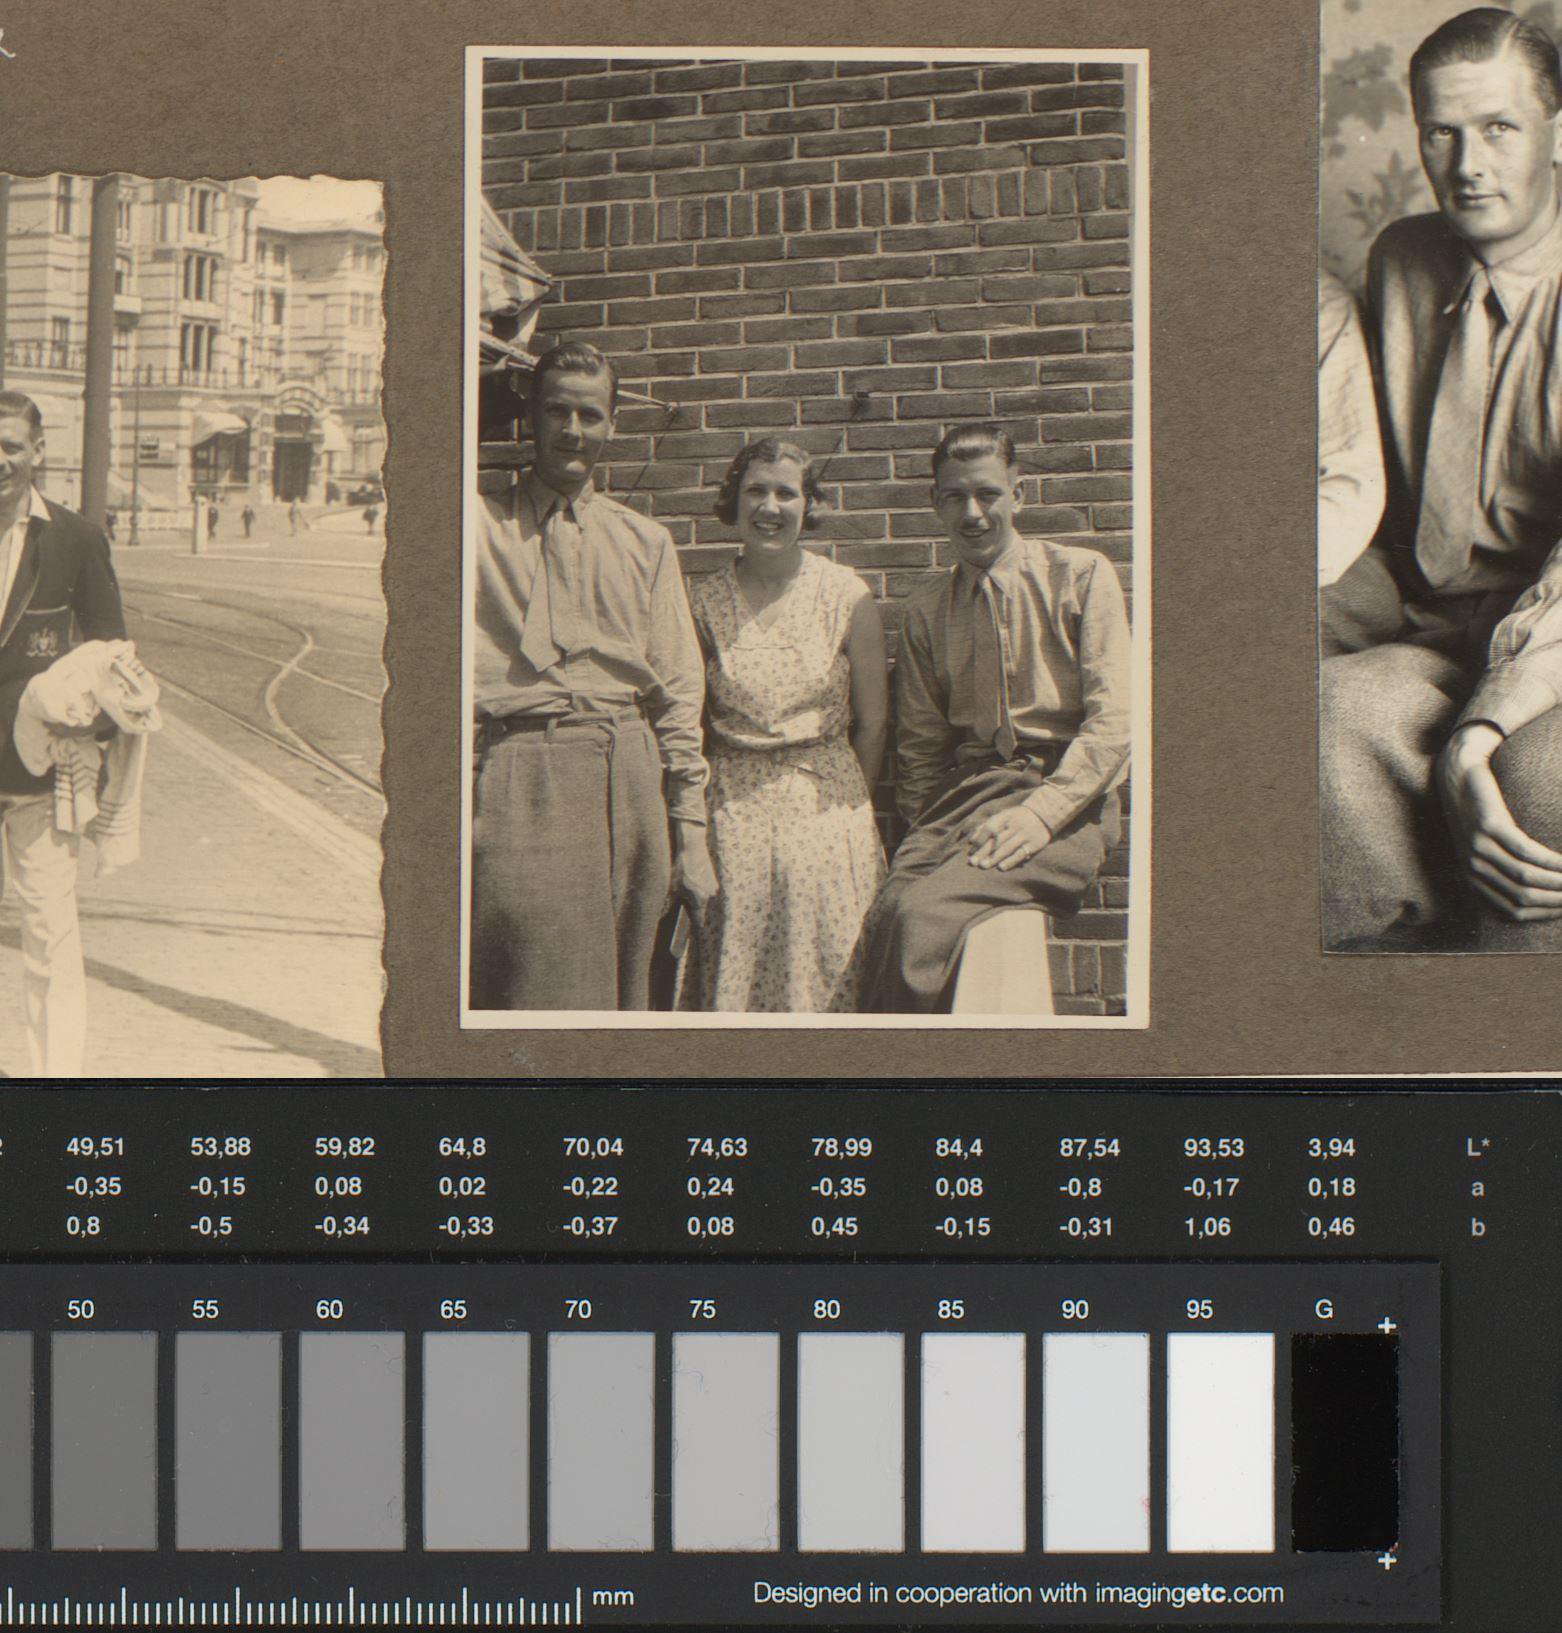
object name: photograph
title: Portret van Basil Cowper, Joyce Bailey en Cyril Barrett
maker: Anonymous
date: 1907-1932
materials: paper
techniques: gelatin silver print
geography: scheveningen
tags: historical persons - bb - woman, historical persons